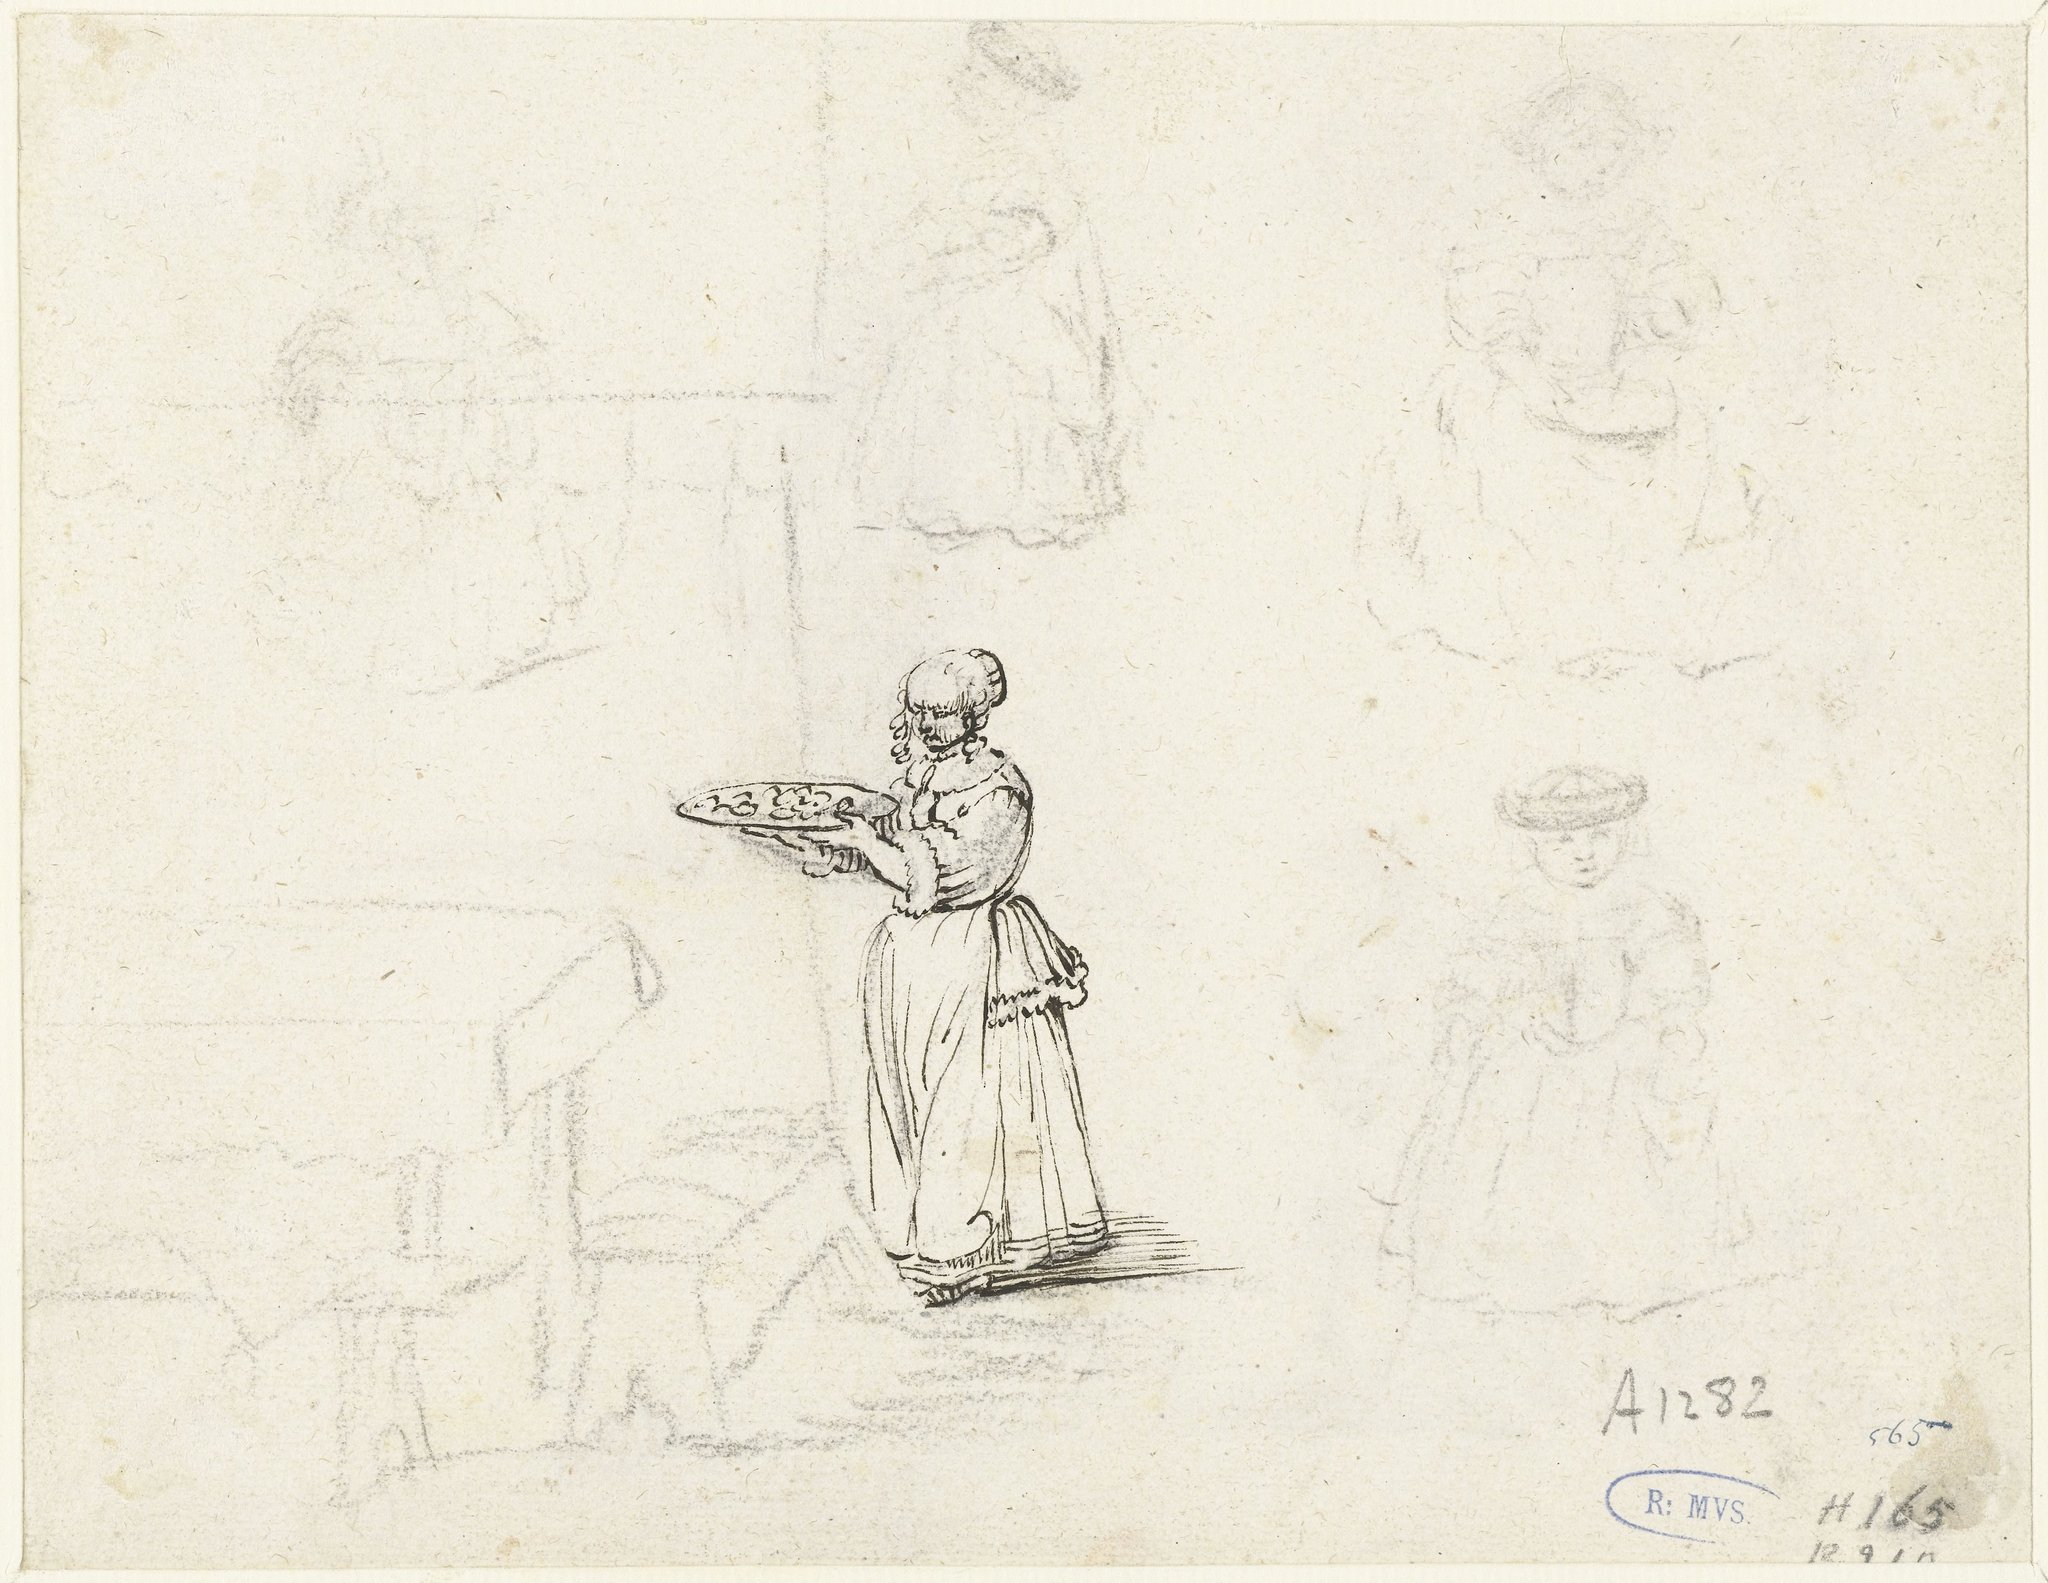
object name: drawing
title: Staande vrouw en schetsen van een kind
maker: gesina ter borch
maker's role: draughtsman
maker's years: 1633-1690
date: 1661-1669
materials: chalk, ink, paper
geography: zwolle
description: De studies van het kind zijn mogelijk bedoeld als voorbereiding op een (nooit afgeronde) aquarel in het Plakboek.